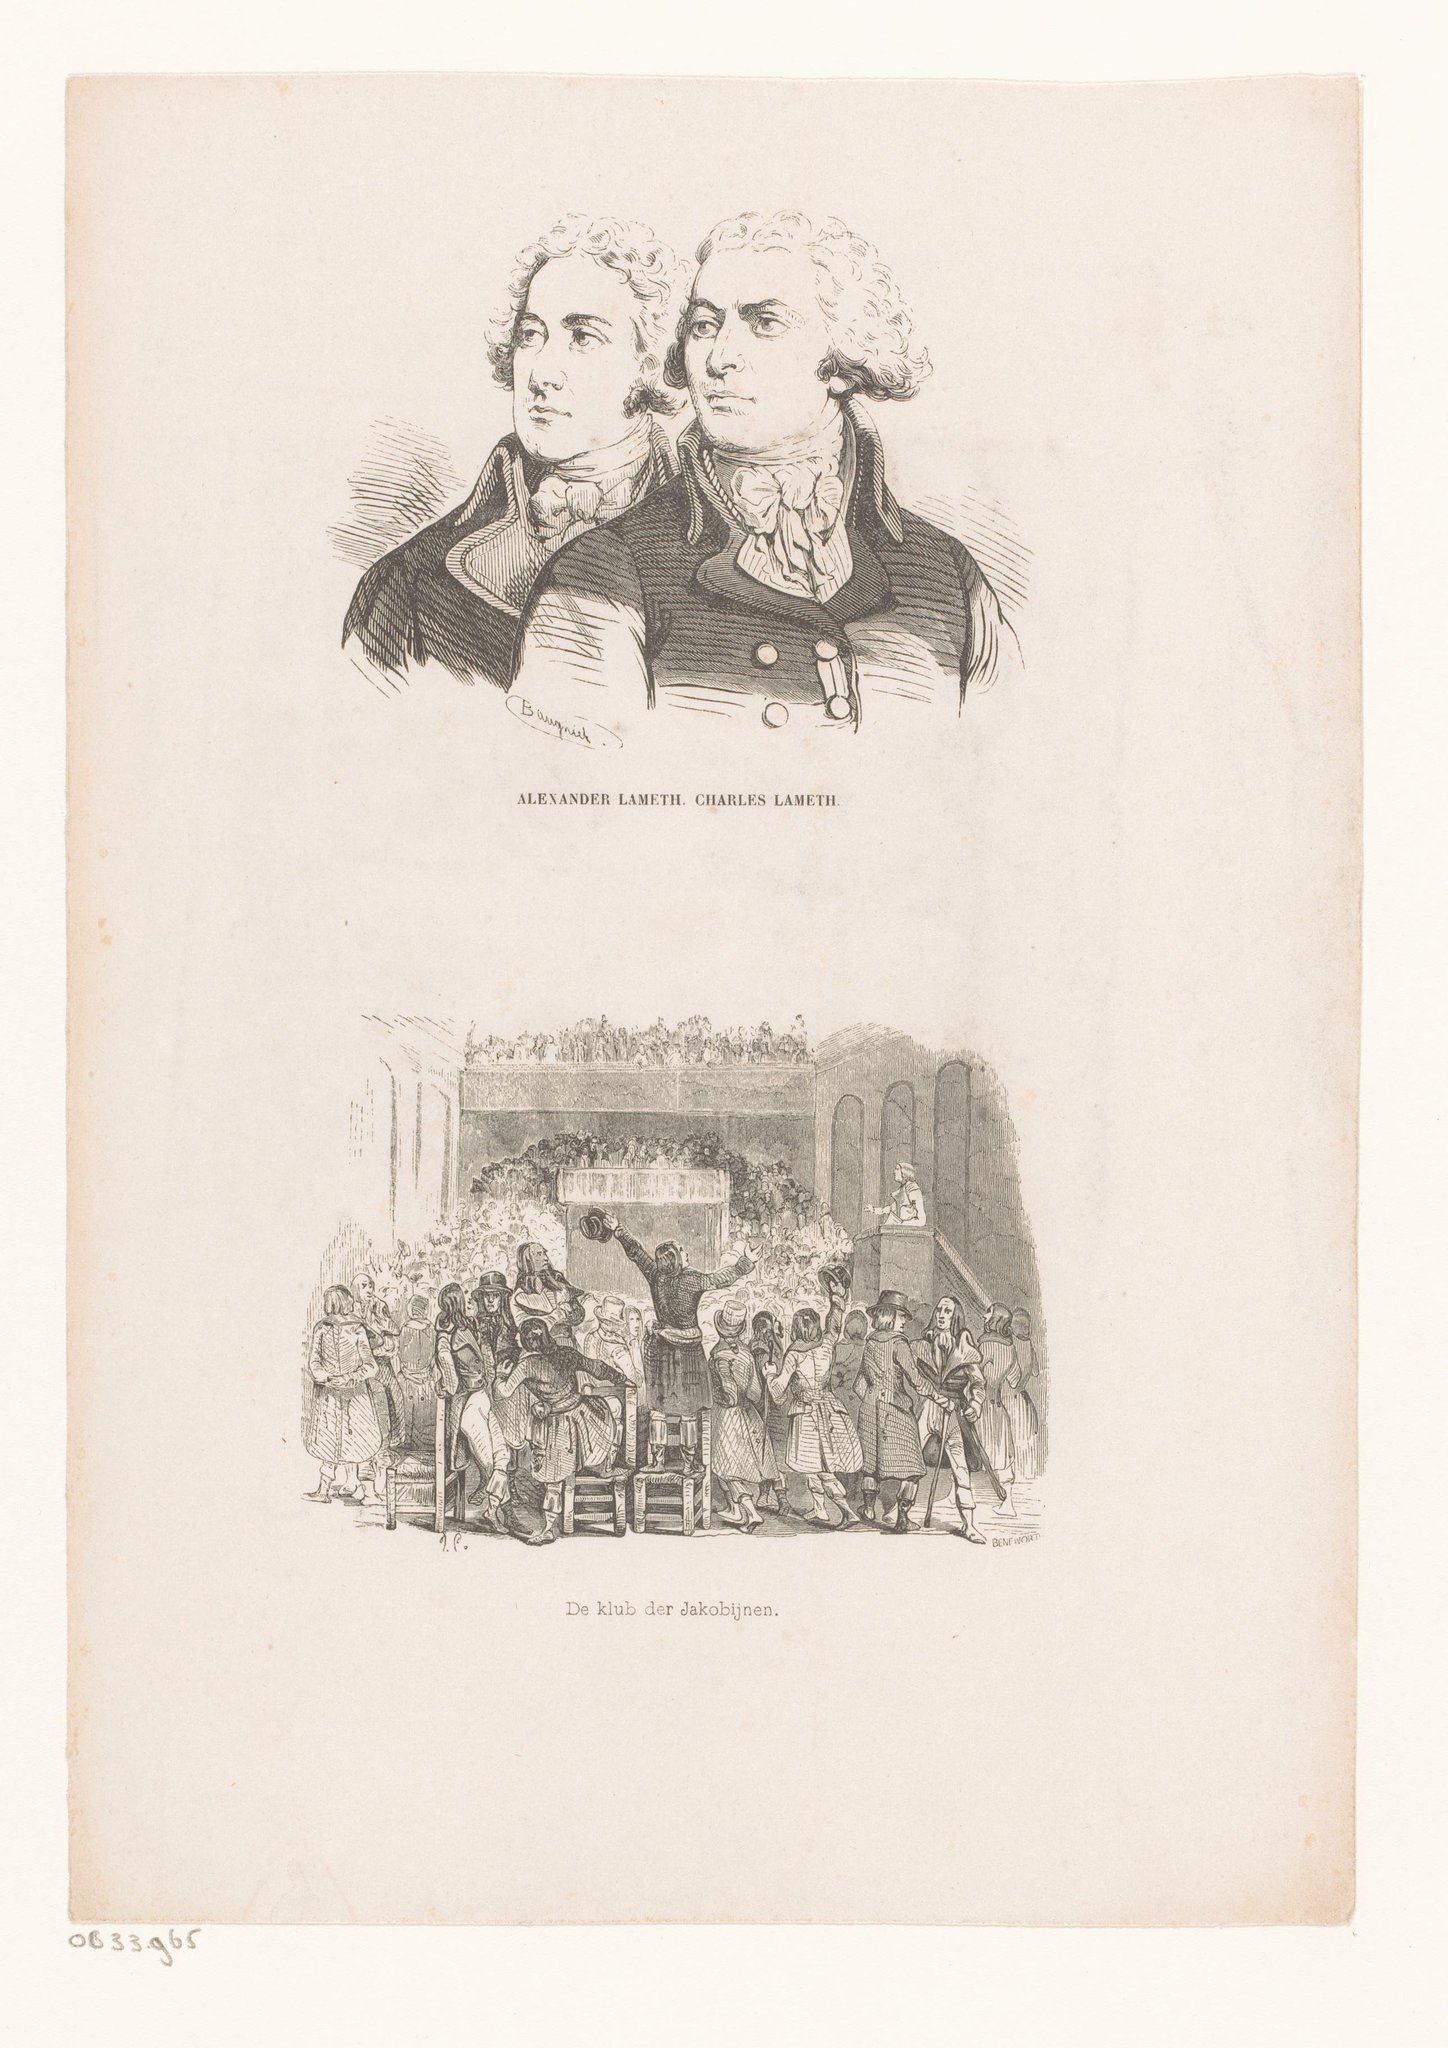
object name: print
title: Alexander Lameth. Charles Lameth/ De klub der Jakobijnen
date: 1824-1886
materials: paper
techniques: engraving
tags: paris, politician, crowd, mob, oral revolutionary action, historical persons